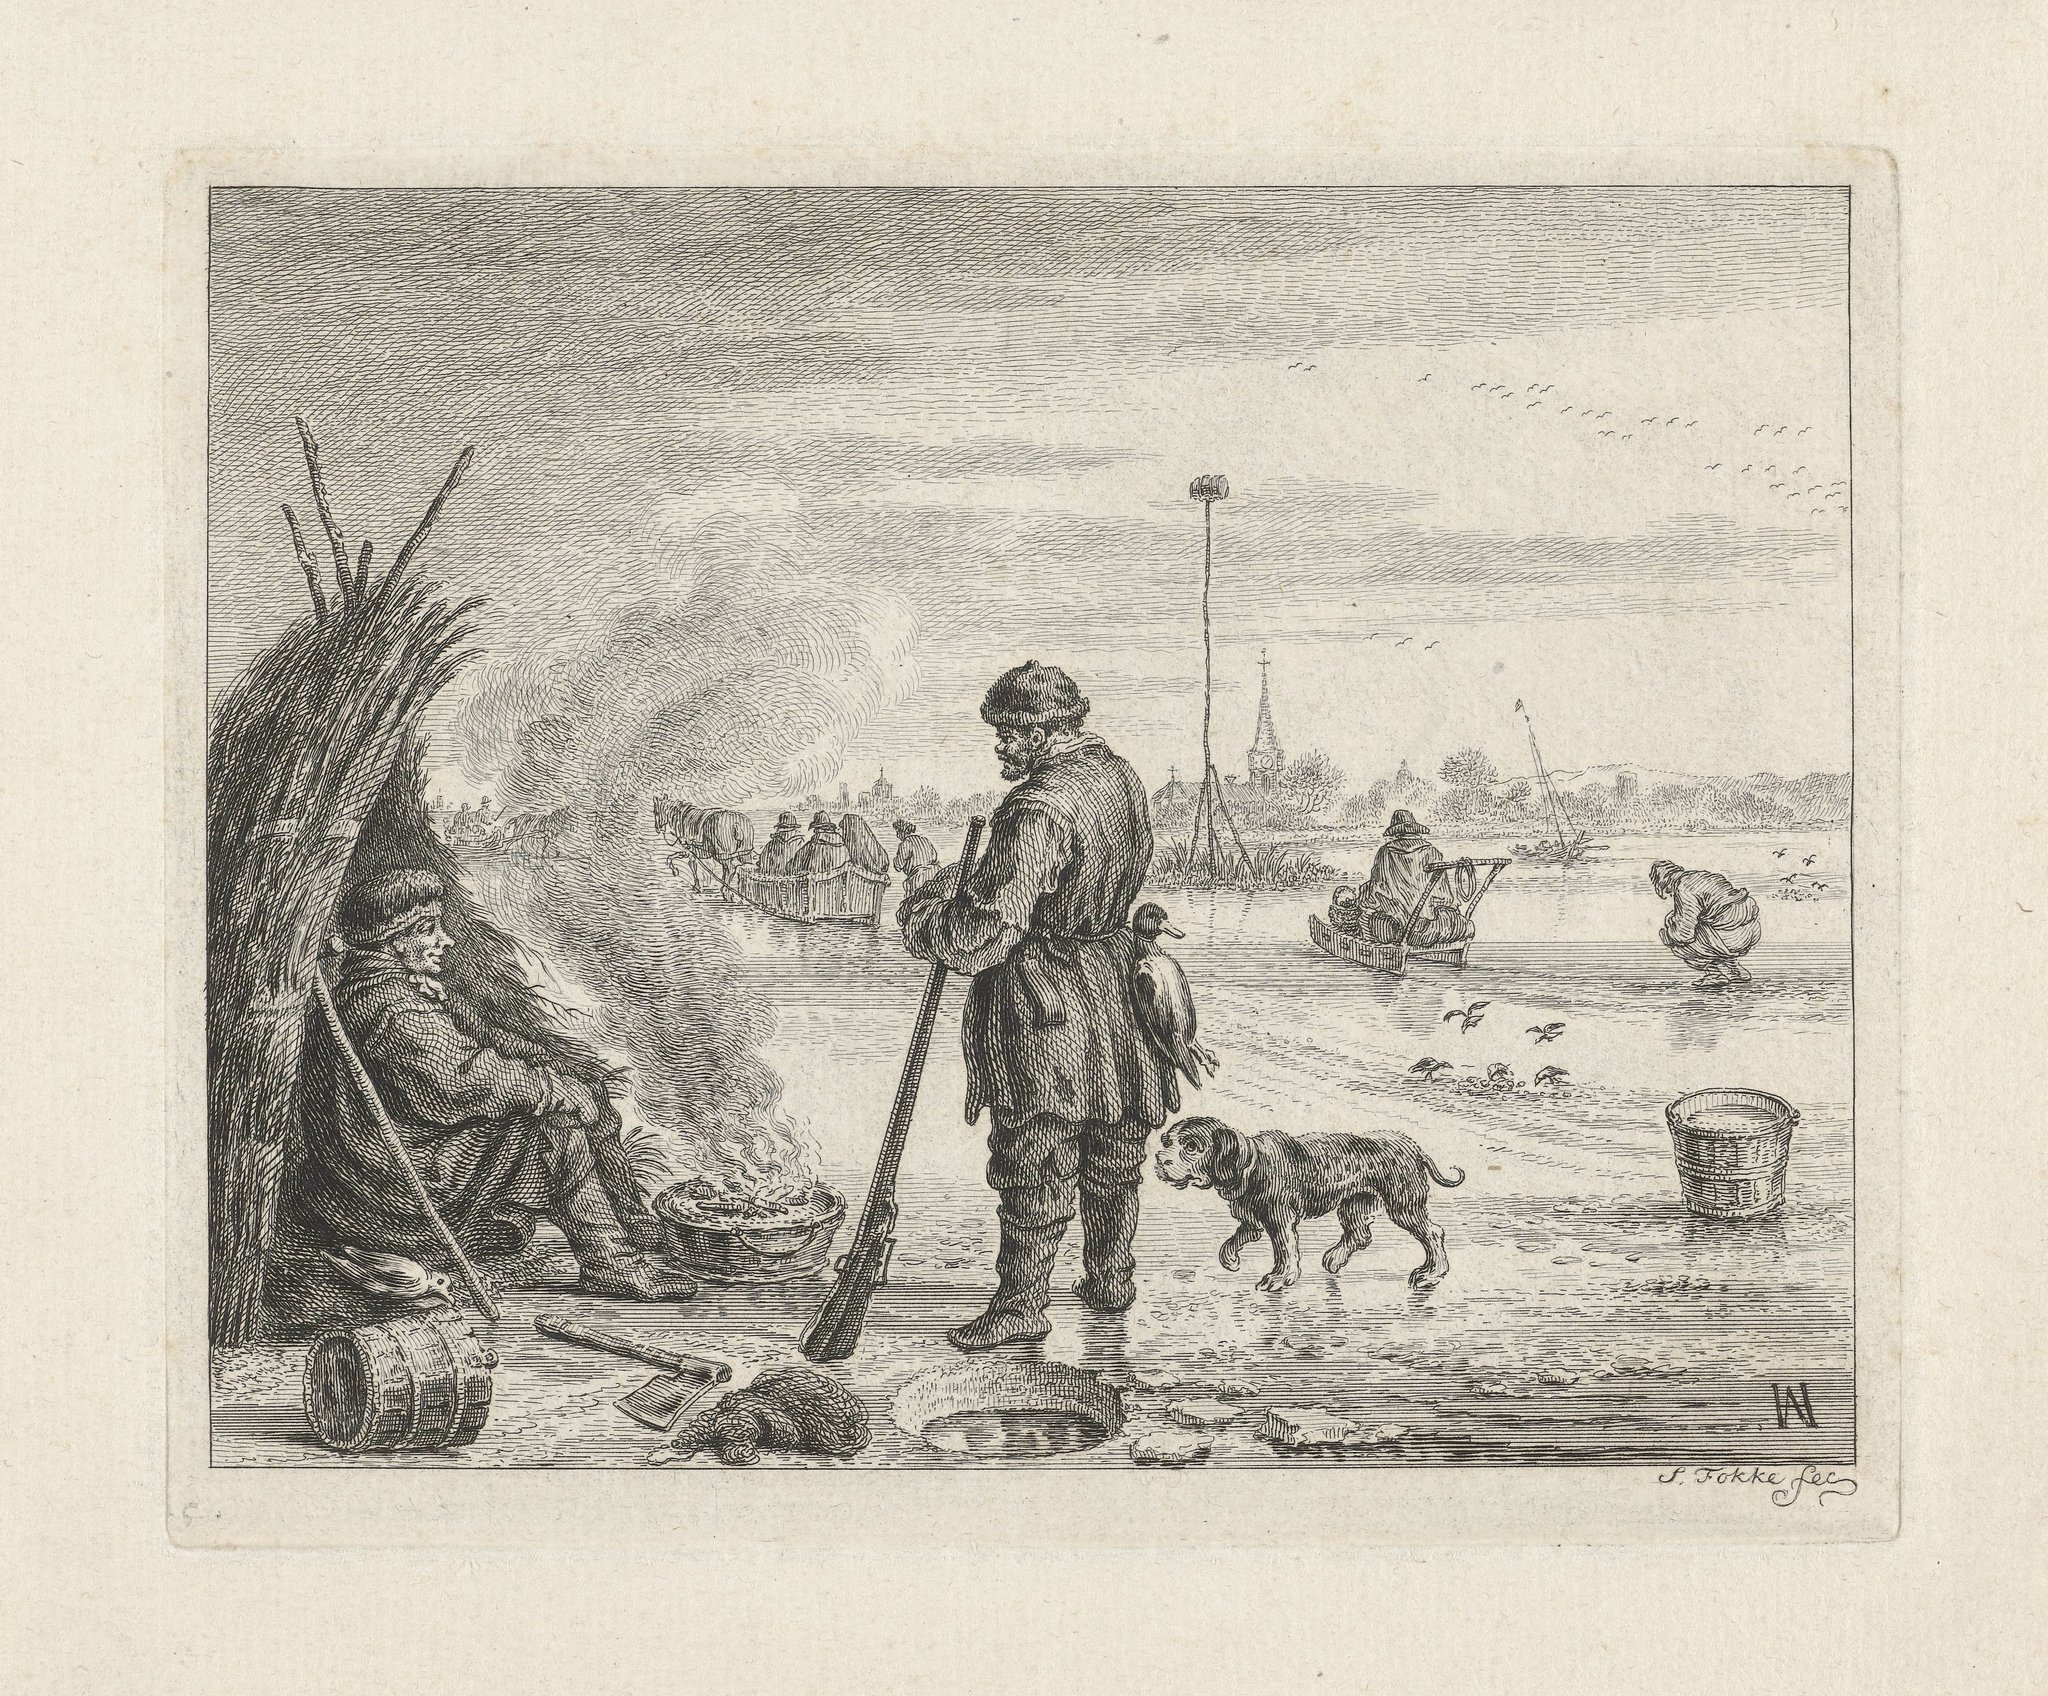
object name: print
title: IJsgezicht nabij Sloten, 1624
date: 1722-1784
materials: paper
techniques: etching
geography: amsterdam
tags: hunter, winter landscape; landscape symbolizing winter (the four seasons of the year), sledge, sleigh (winter sports), fisherman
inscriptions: collector's mark: Lugt 240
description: IJsgezicht nabij Sloten met op de voorgrond een jager en een visser. Op het ijs worden personen per slee vervoerd. Geheel rechts doet een man zijn behoefte op het ijs.